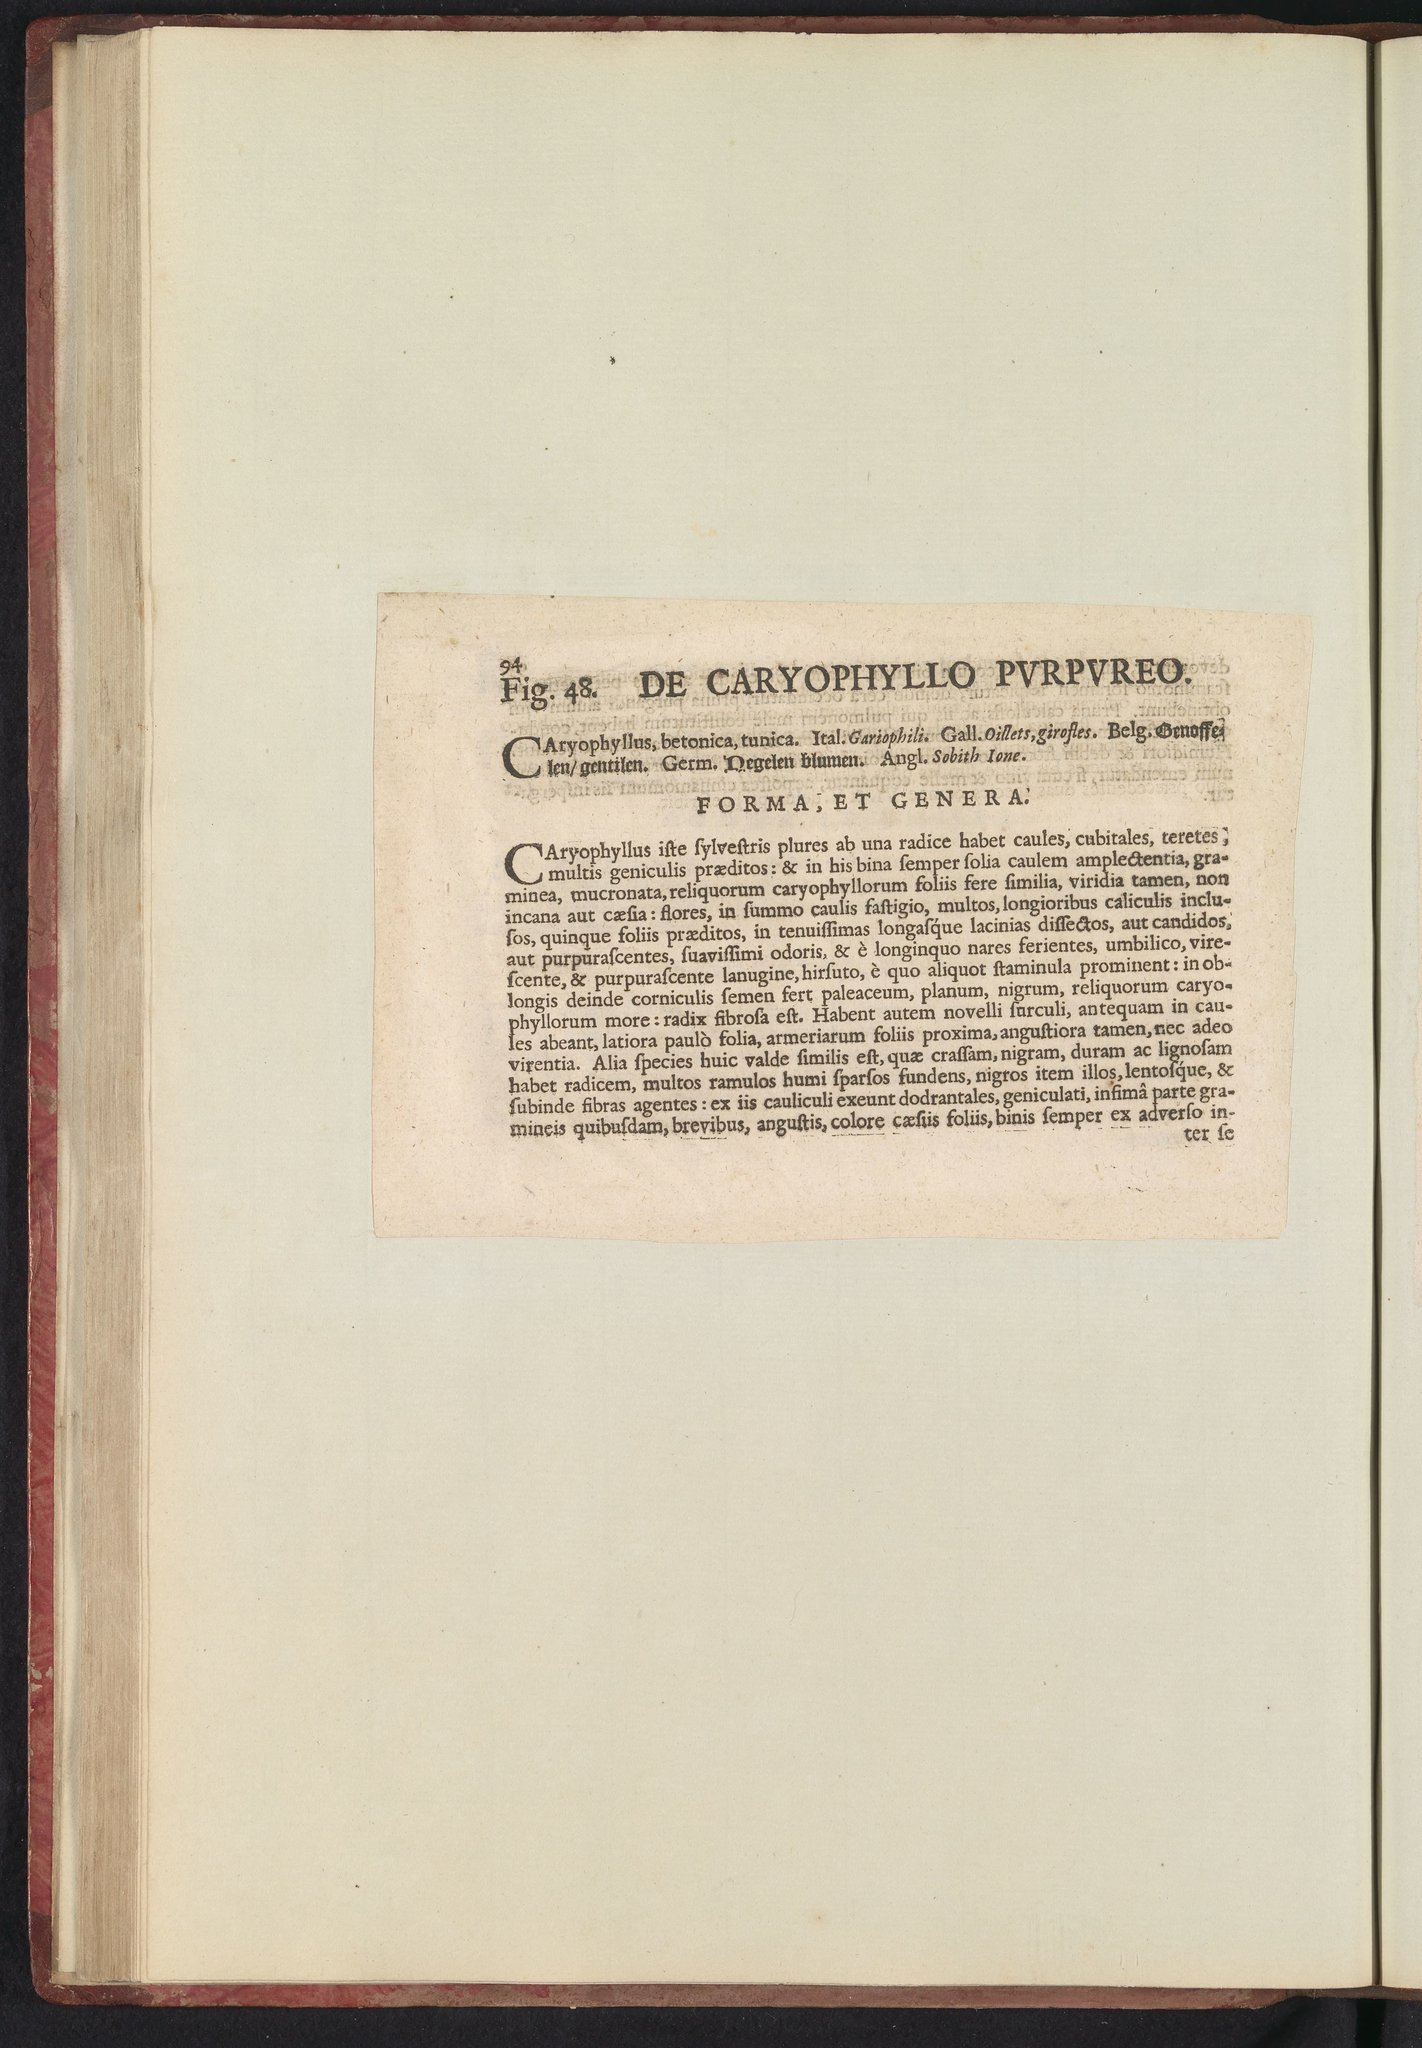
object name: text sheet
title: Fig. 48 'De Caryophyllo Pvrpvreo' in De Boodts herbarium van 1640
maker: anselmus boëtius de boodt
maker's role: draughtsman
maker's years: 1550-1632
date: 1640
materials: ink, paper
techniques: letterpress printing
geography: bruges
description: Beschrijving bij Fig. 48 op p. 94 in: Anselmi Boëtii de Boot I.C. Brugensis & Rodolphi II. Imp. Roman. medici a cubiculis Florum, Herbarum, ac fructuum selectiorum icones, & vires pleraeque hactenus ignotæ. Onderdeel van het album met bladen en platen uit De Boodts herbarium van 1640. Het twaalfde van twaalf albums met aquarellen van dieren, vogels en planten bekend rond 1600, gemaakt in opdracht van keizer Rudolf II.